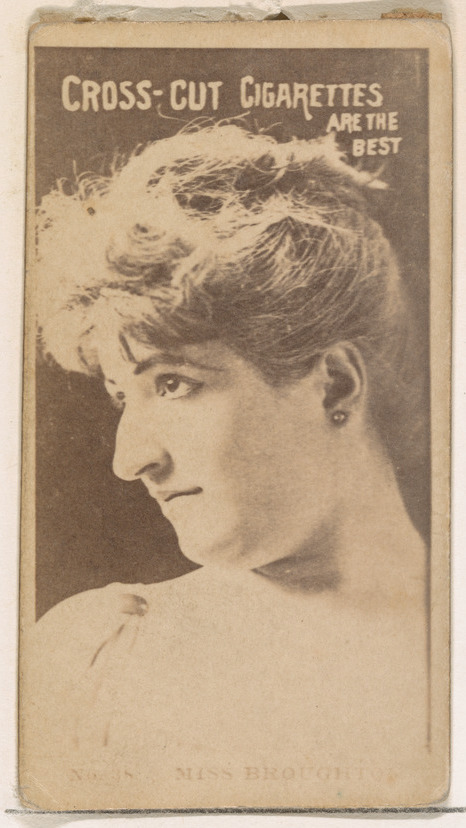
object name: print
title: Card Number 16, Miss Broughton, from the Actors and Actresses series (N145-2) issued by Duke Sons & Co. to promote Cross Cut Cigarettes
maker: w. duke, sons & co.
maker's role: publisher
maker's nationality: american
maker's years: 1870-1920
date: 1880-1889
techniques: albumen silver print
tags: women,actresses